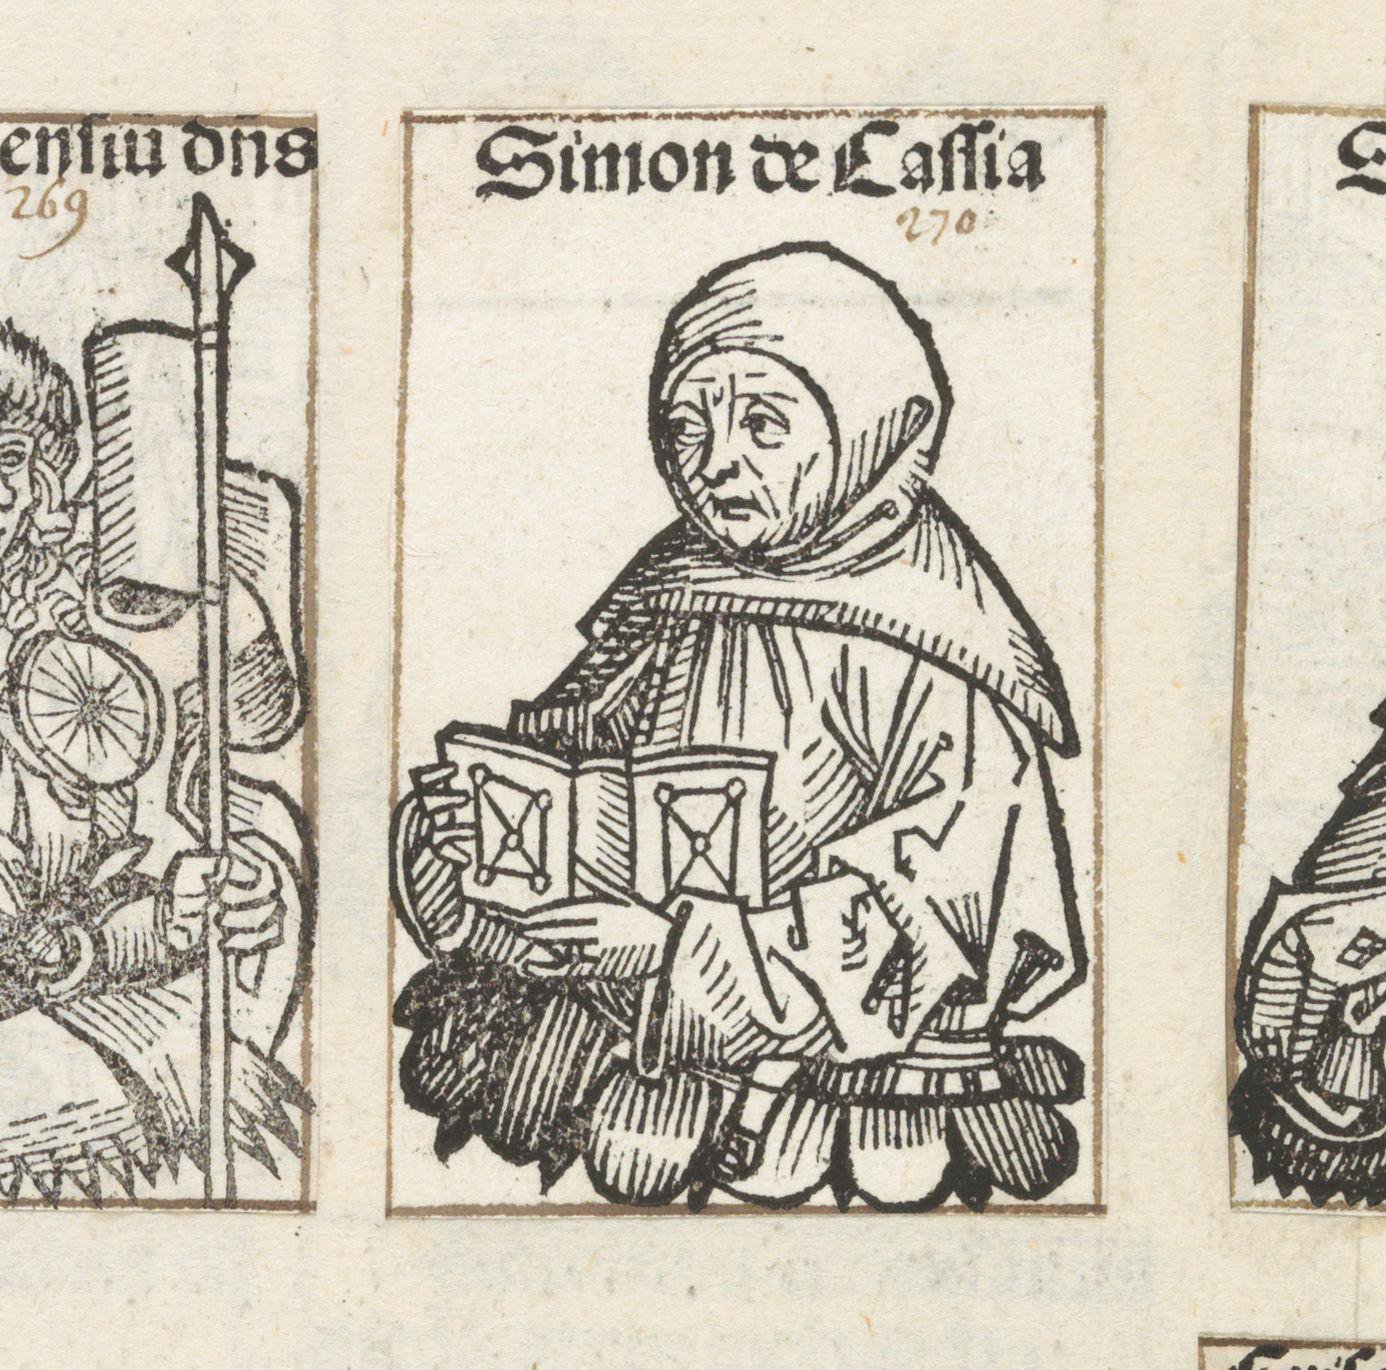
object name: book illustration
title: Liber Chronicarum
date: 1493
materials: paper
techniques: letterpress printing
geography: nuremberg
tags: clergyman, monk(s), friar(s)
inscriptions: inscription: ‘270’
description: De houtsnede wordt herhaaldelijk gebruikt als boekillustratie in de Liber Chronicarum (of Neurenbergkroniek) van Hartmann Schedel, verschenen in het Latijn en Duits in 1493. Zie de Latijnse uitgave, folio 234v.